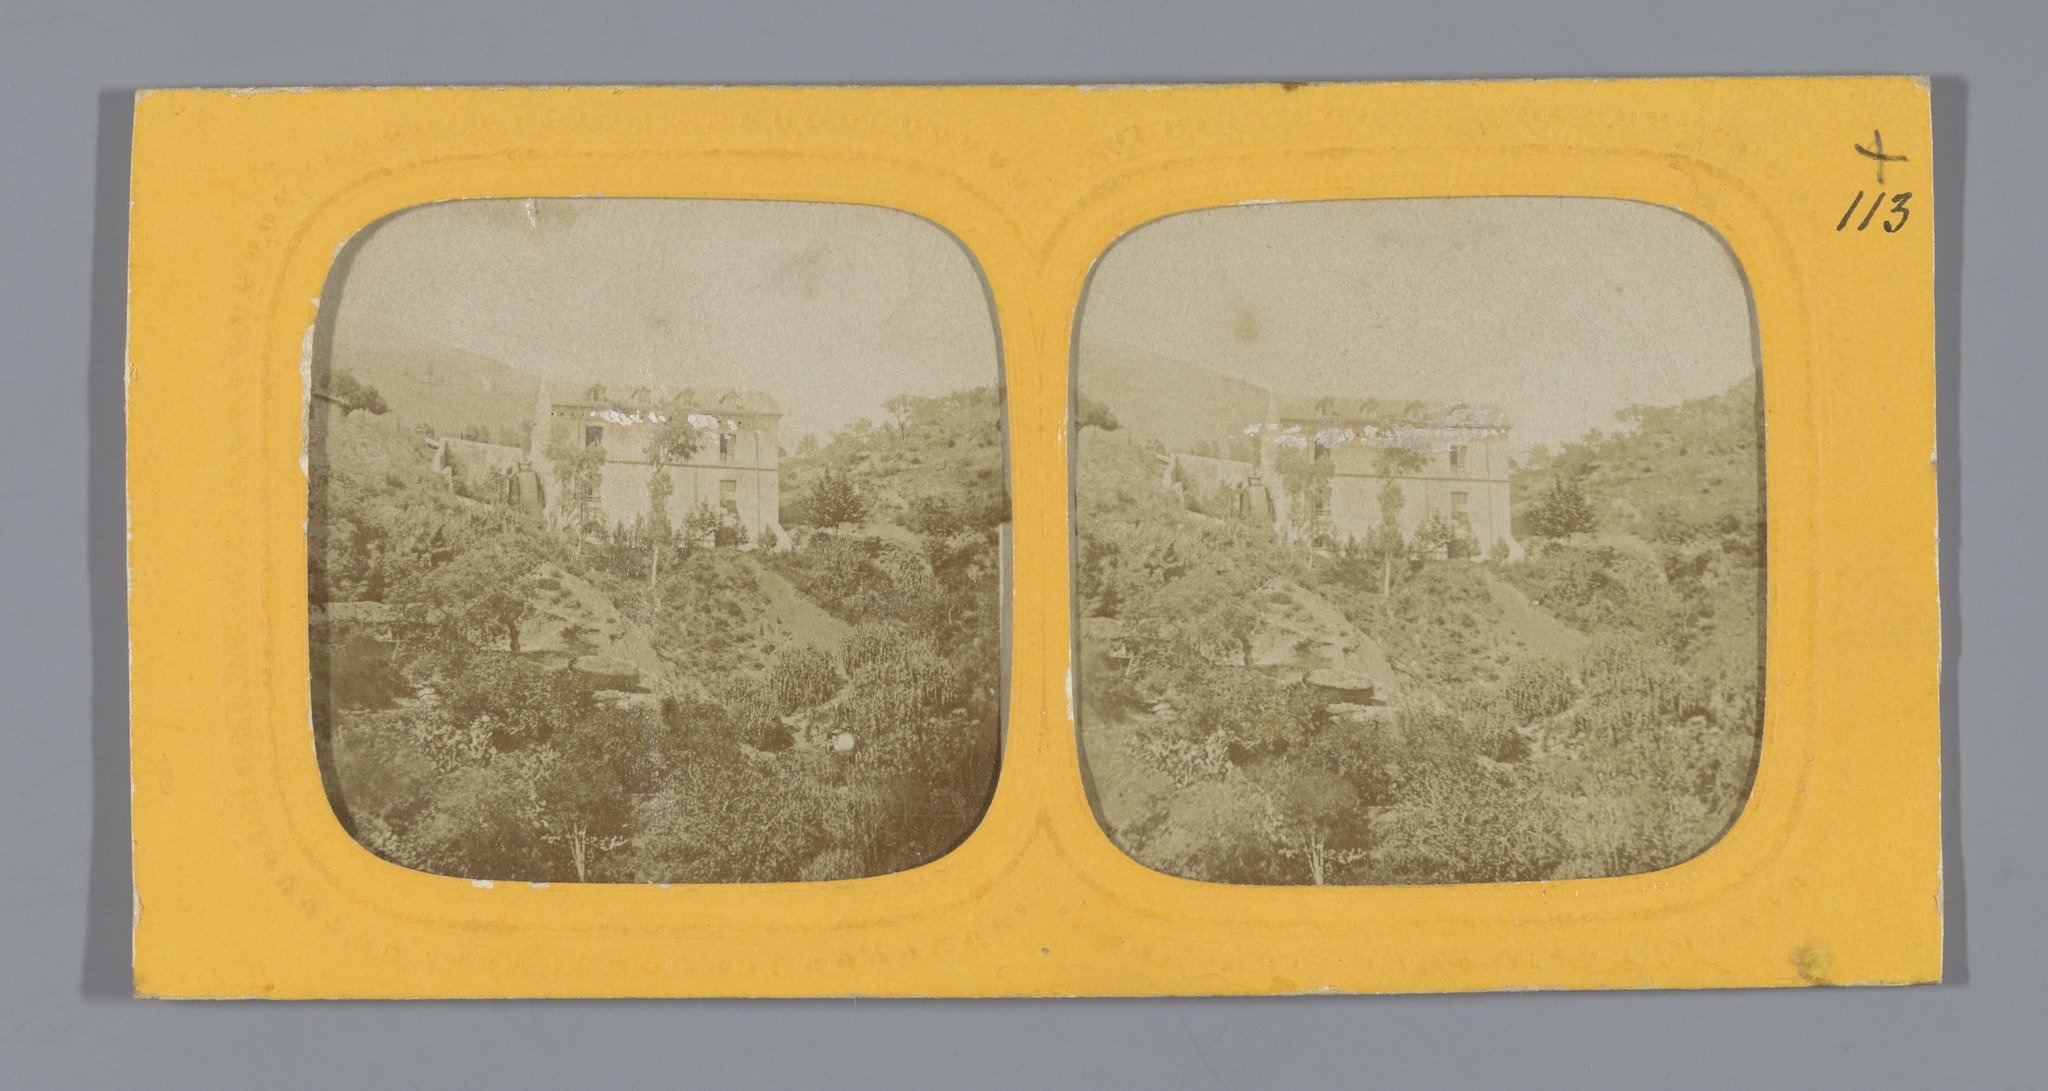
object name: tissue stereograph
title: Boerderij te Cachron in Algiers / Ferme à Cachron Algerie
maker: Anonymous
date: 1865-1875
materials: cardboard, paper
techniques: albumen print, hand coloring, perforating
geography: algiers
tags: farm or solitary house in landscape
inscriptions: monogram: ‘E.L.’, inscription: ‘+/ 113’